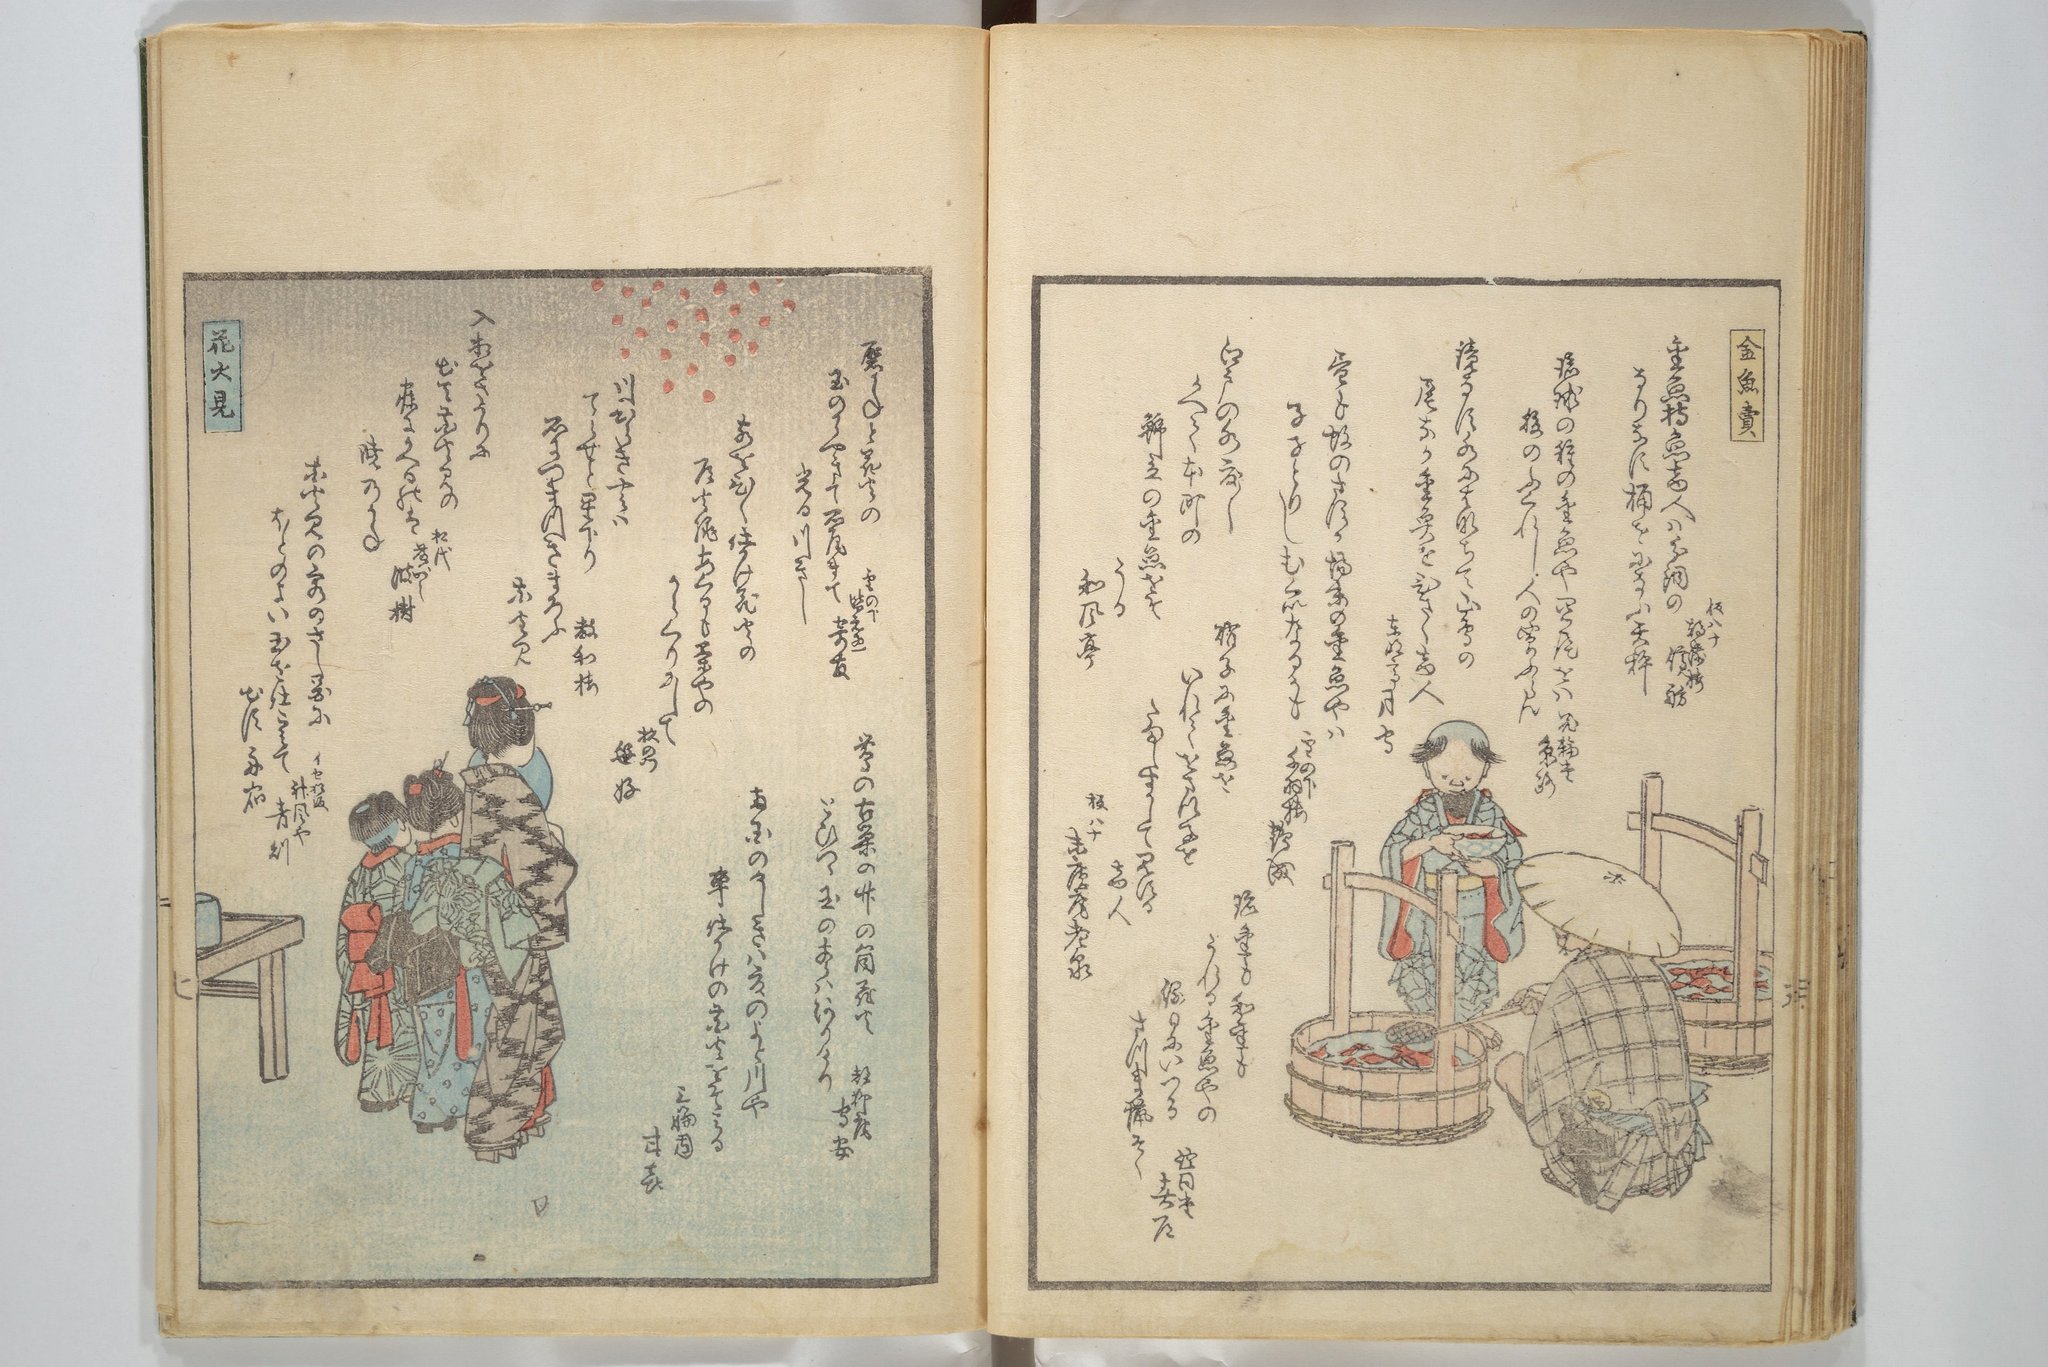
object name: illustrated book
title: Picture Album of People with Kyōka (Light Verse) (Kyōka shiki jinbutsu) 狂歌四季人物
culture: japanese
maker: utagawa hiroshige 歌川広重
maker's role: artist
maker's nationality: japanese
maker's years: 1797-1858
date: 1855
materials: ink, paper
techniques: woodblock print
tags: men,fish